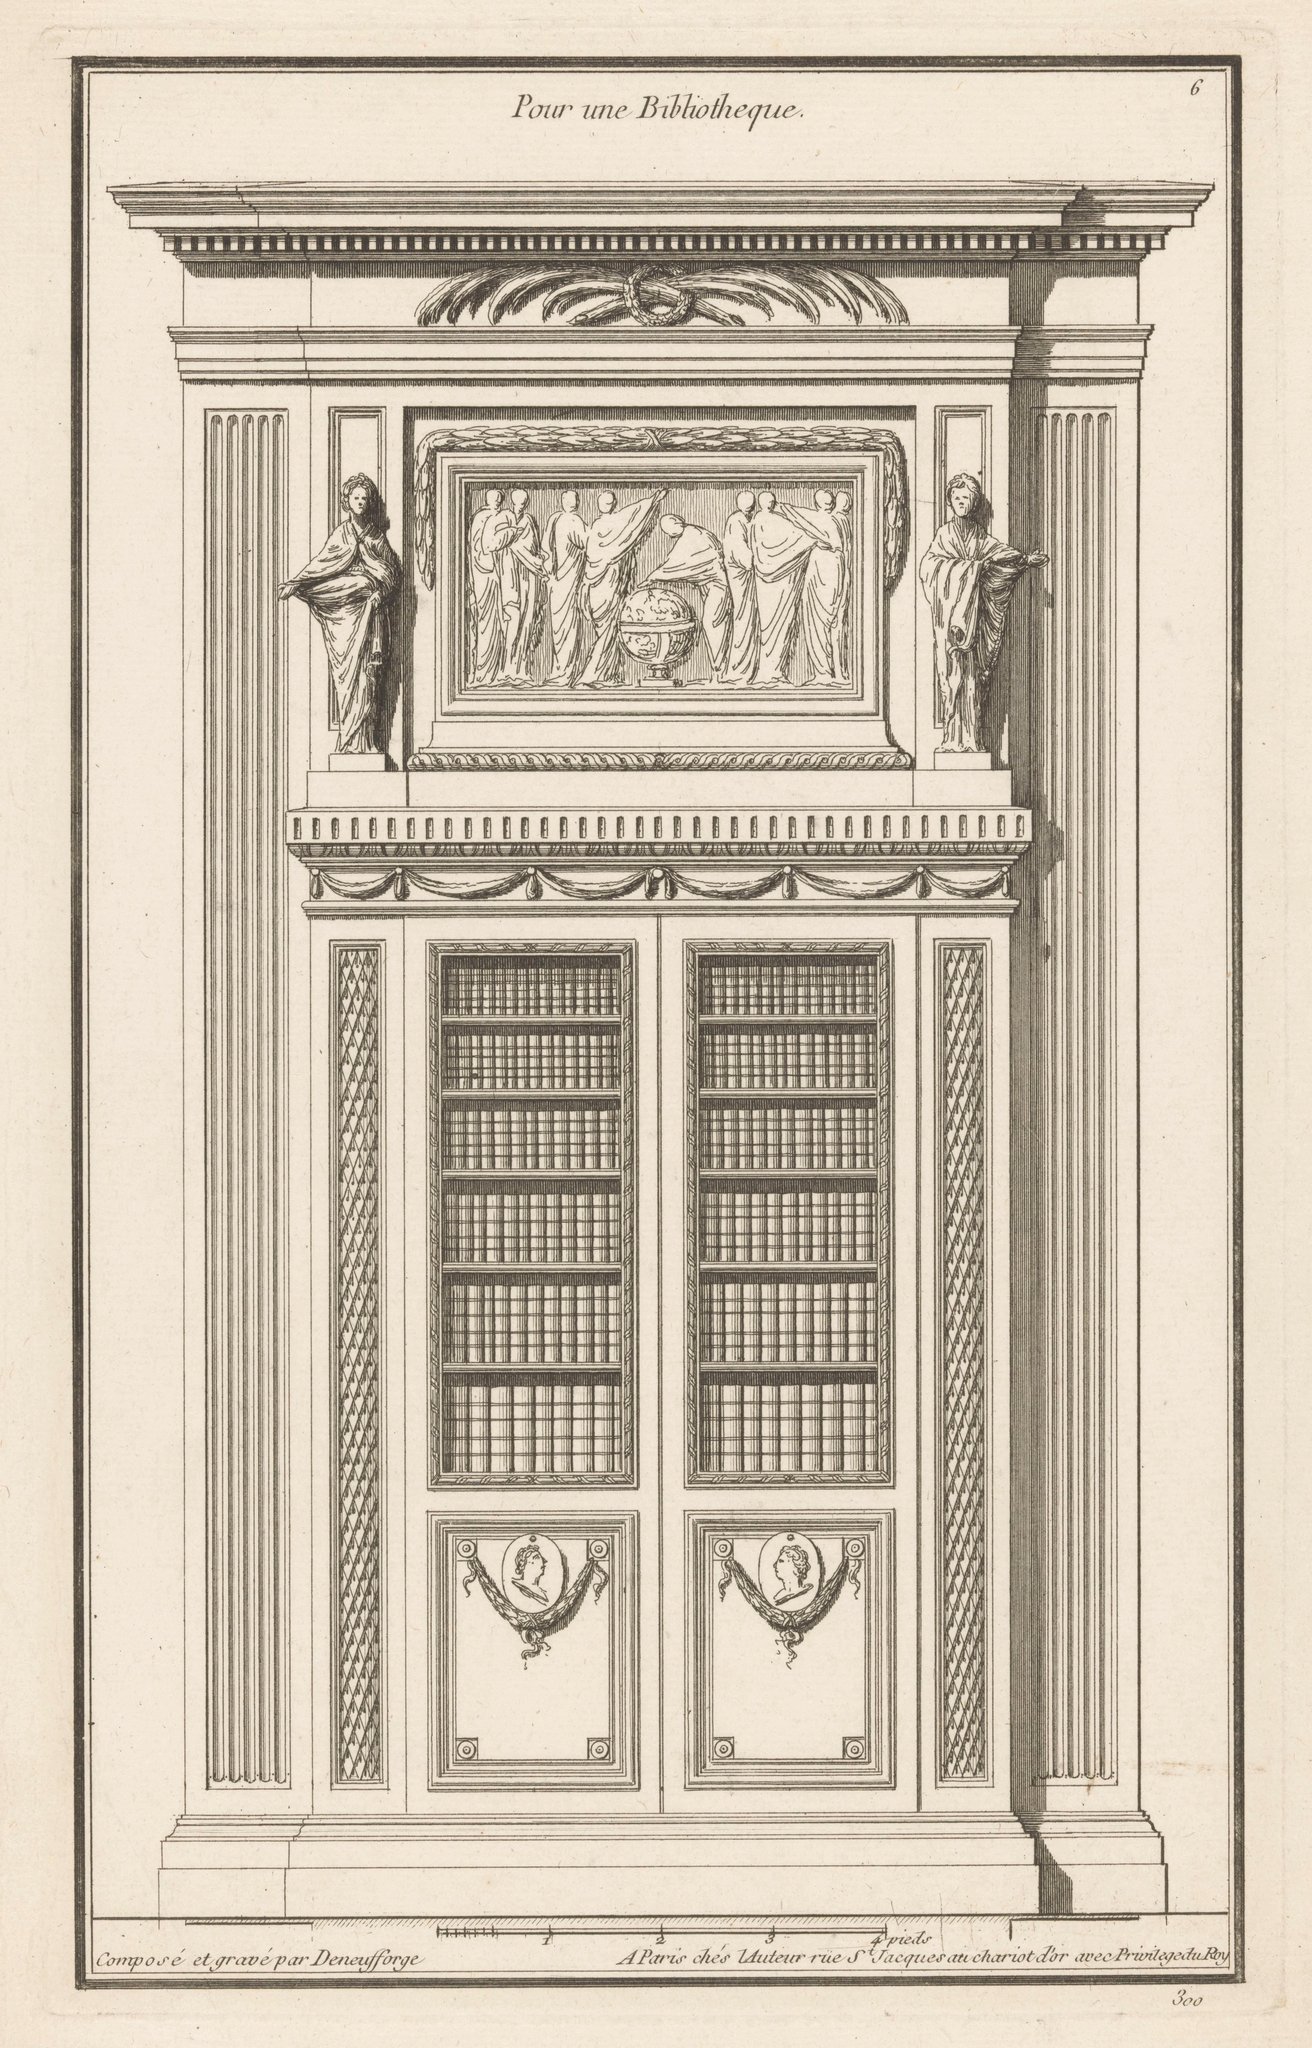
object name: print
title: Cinquième Volume, Recueil élémentaire d'architecture (...)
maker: jean françois de neufforge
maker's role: print maker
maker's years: 1714-1791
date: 1763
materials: paper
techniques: etching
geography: paris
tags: bookshelves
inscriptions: collector's mark: Lugt 2228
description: Een geornamenteerde boekenkast met op de onderste deuren medaillons met portretten en guirlandes. Boven de kast een paneel met figuren rondom een globe, geflankeerd door beelden van staande figuren. Prentnummer 300.